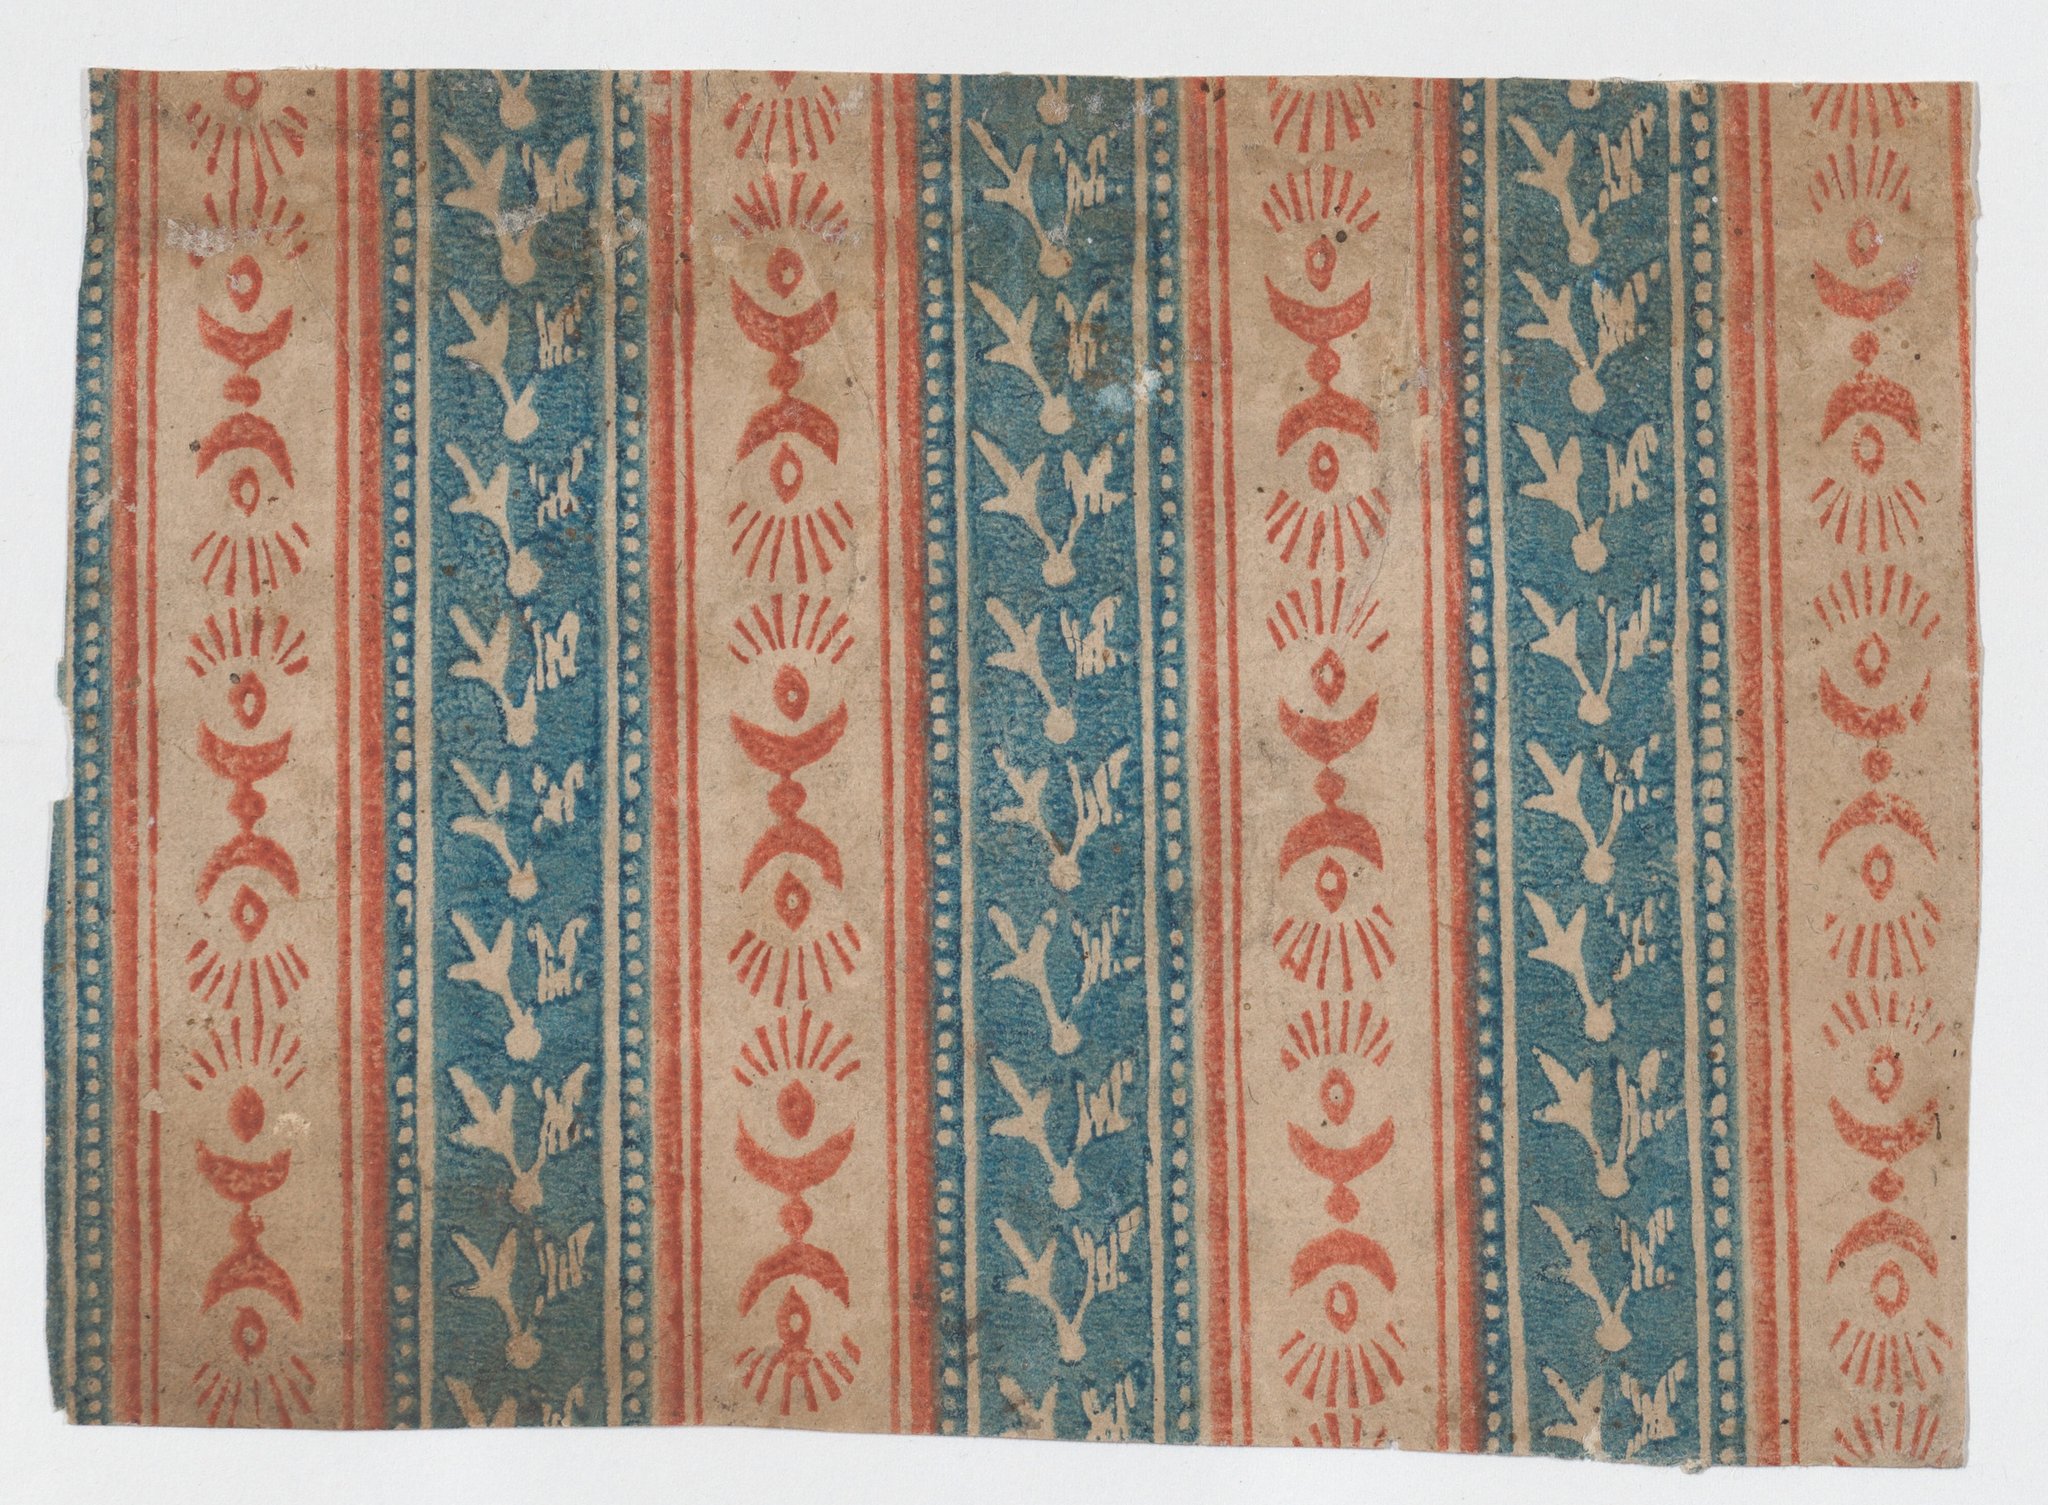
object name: print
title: Sheet with four borders with abstract designs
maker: Anonymous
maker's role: artist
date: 1801-1900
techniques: relief print